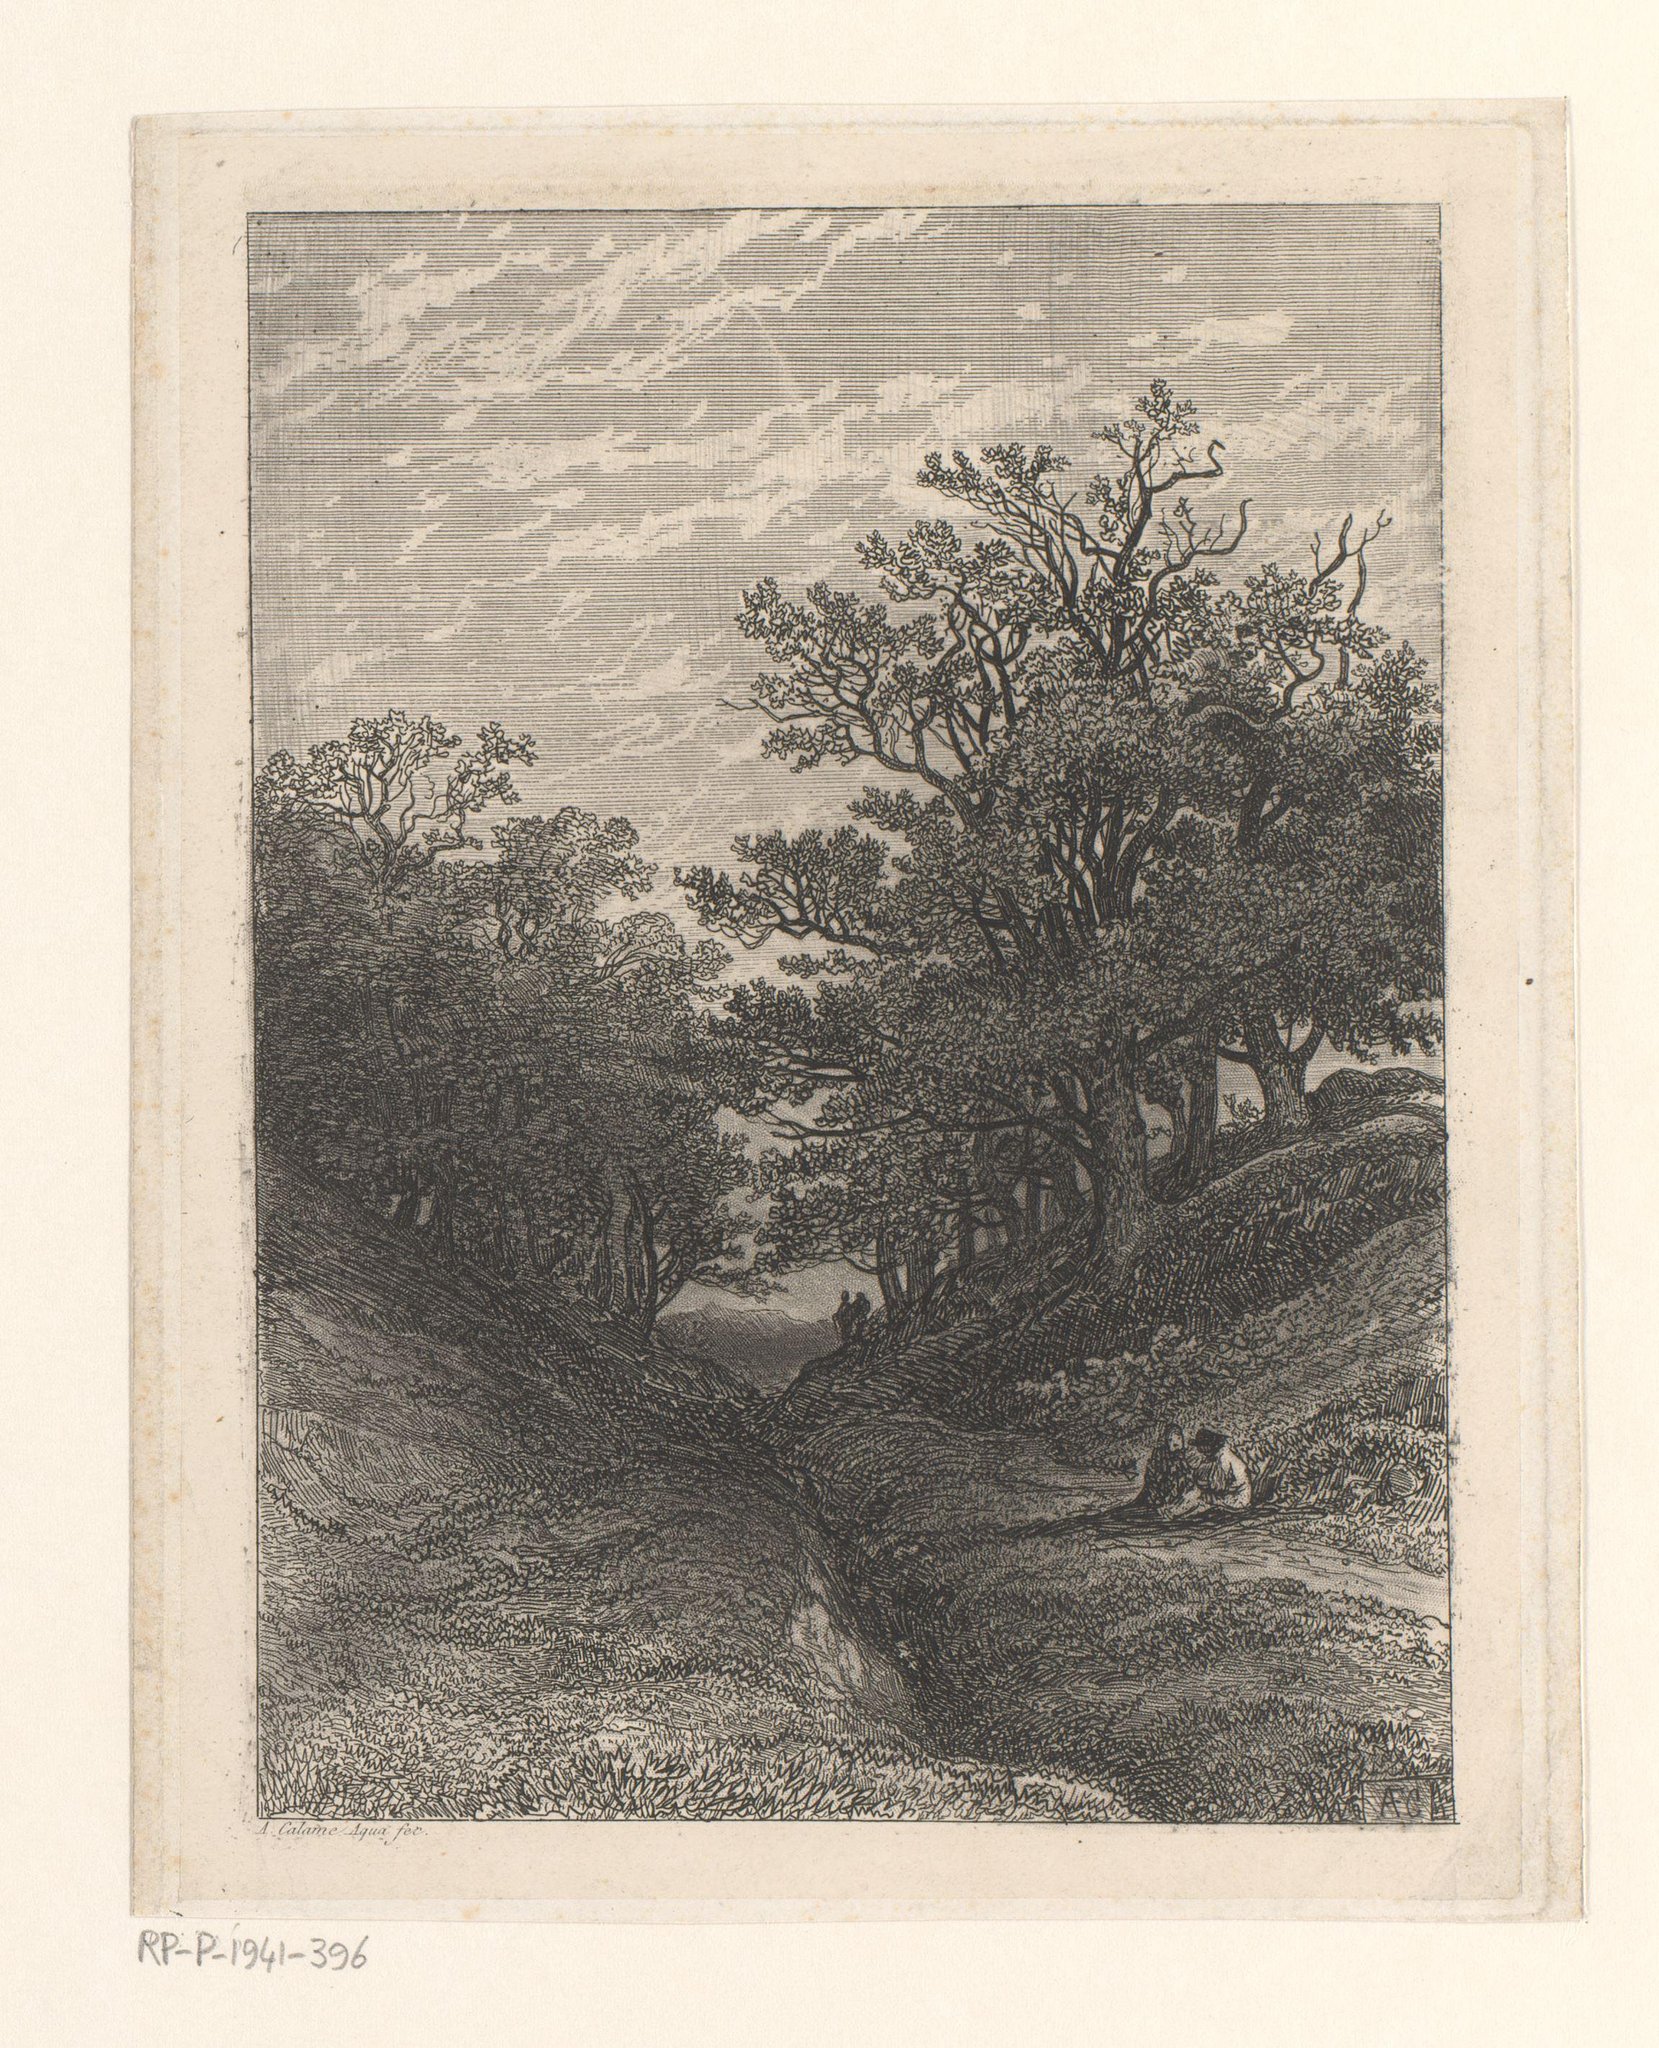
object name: print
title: Heuvellandschap met figuren aan een pad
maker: alexandre calame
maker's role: draughtsman, painter, print maker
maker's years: 1810-1864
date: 1820-1864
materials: paper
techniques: etching, roulette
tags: trees, landscapes (+ landscape with figures, staffage), mountains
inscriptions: collector's mark: Lugt 2228, collector's mark: Lugt 2760